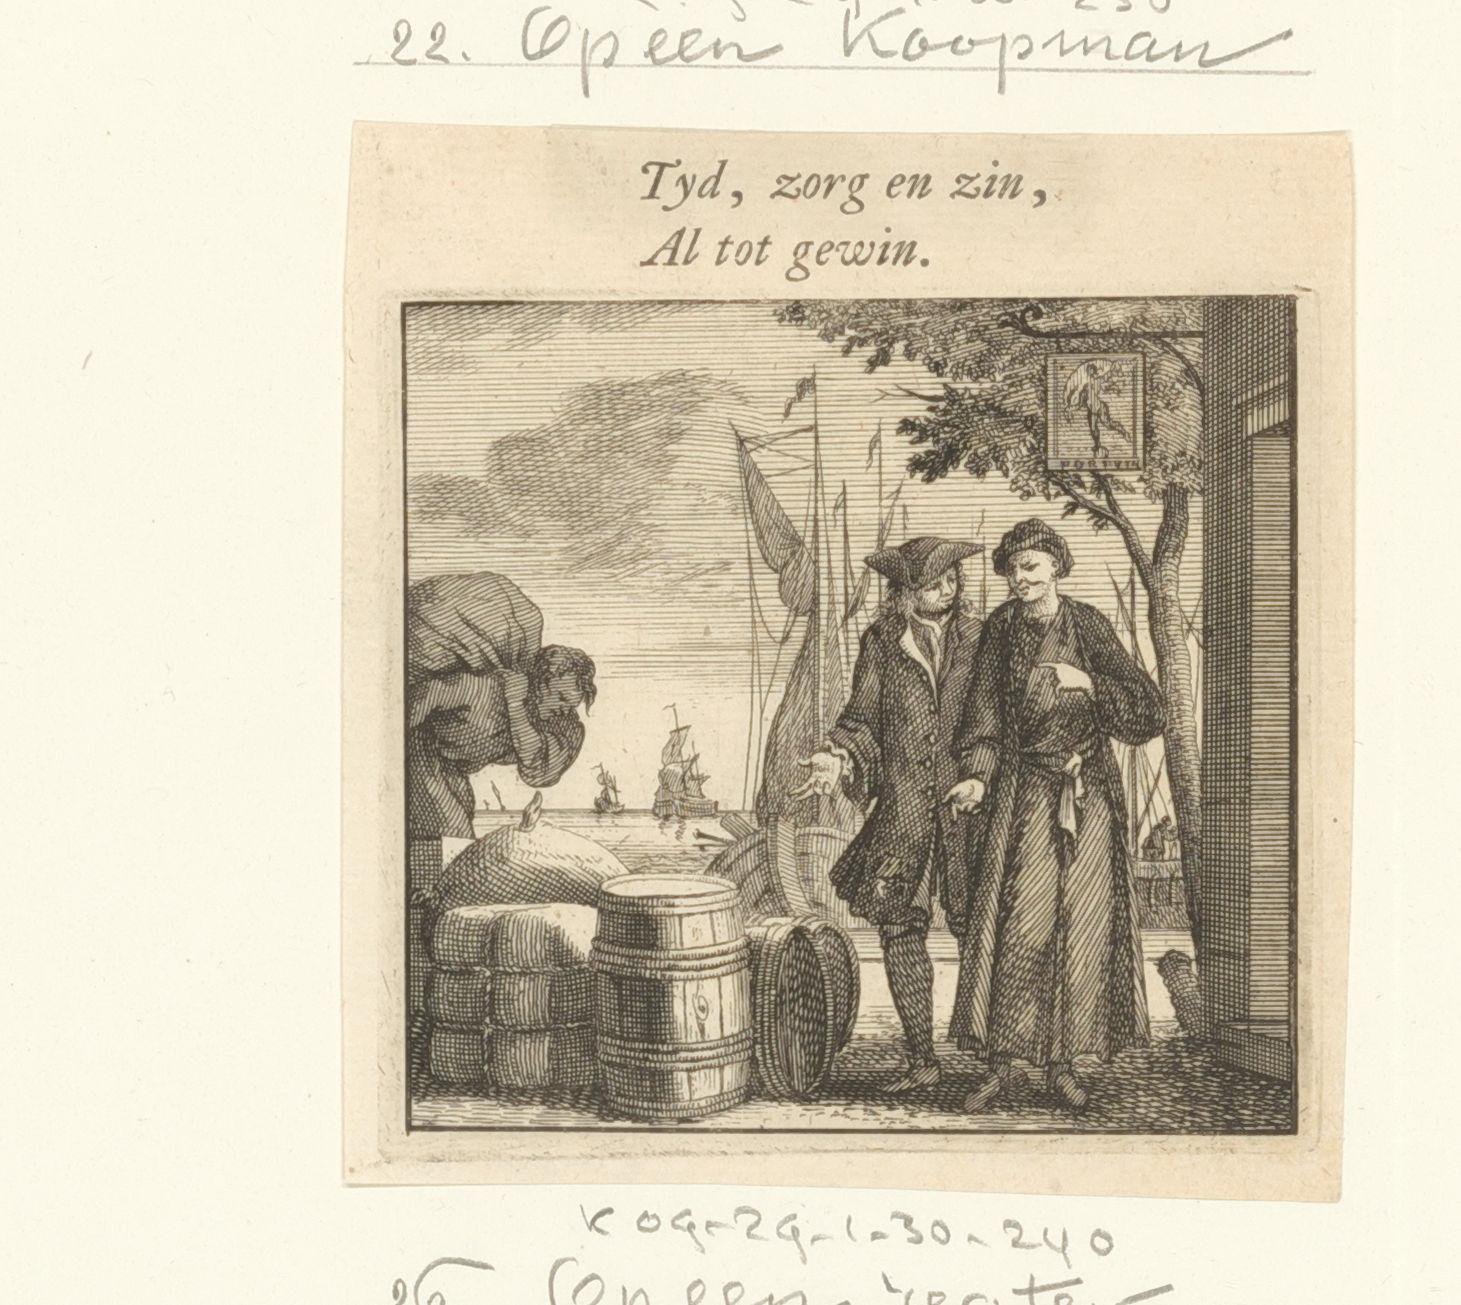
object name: print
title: Twee koopmannen bekijken de lading van een schip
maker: cornelis huyberts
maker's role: print maker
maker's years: 1669-1709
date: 1725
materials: paper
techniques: etching, letterpress printing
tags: merchant, salesman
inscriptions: stamp, collector's mark: Lugt 1641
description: Prent uit: Graauwhart, Hendrik. Voorbeeldelyke zeede-lessen, genoomen uyt den eersten toestand des werelds (...). Amsterdam: Johannes Ratelband, 1725. Prent ook gebruikt voor eerdere en (1709) latere uitgave (1756, 1761 en 1764).